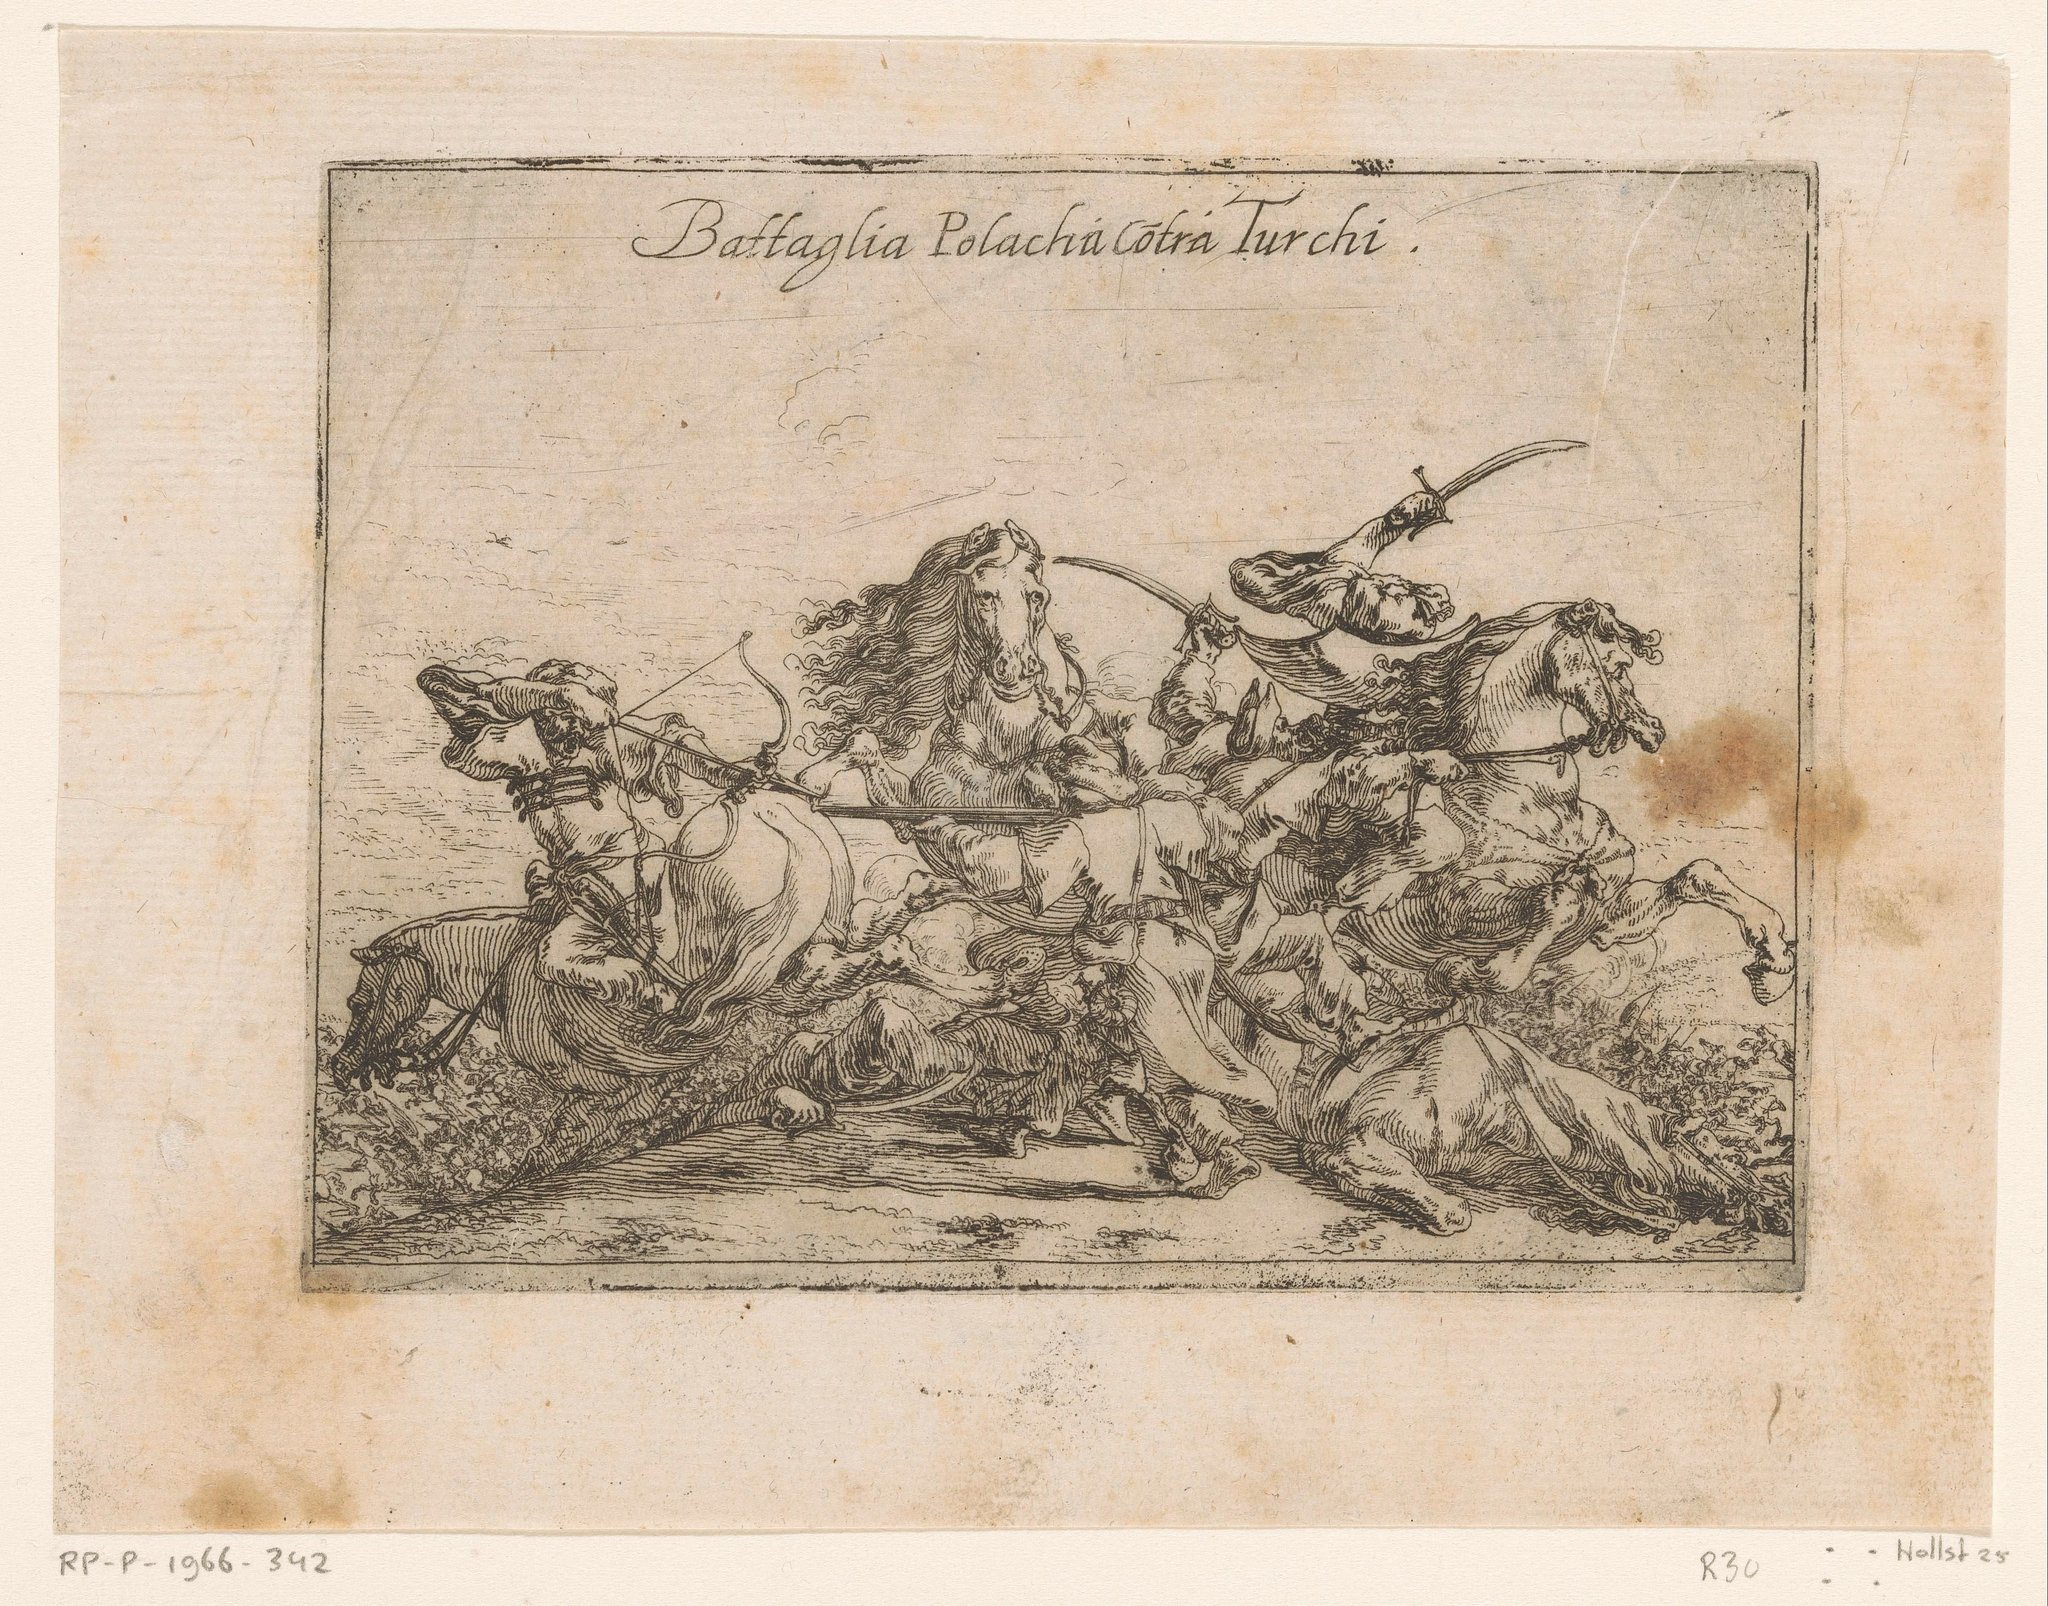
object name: print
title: Battaglia Polachi contra Turchi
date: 1633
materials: paper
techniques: etching, intaglio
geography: italy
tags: asiatic races and peoples: turks, battle (+ infantry), battle (+ cavalry, horsemen), europeans (with name)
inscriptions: collector's mark: Lugt 2228, collector's mark: Lugt 5k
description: Zevende prent uit de serie 'Veldslagen door verschillende volkeren', bestaand uit een titelprent en dertien prenten.